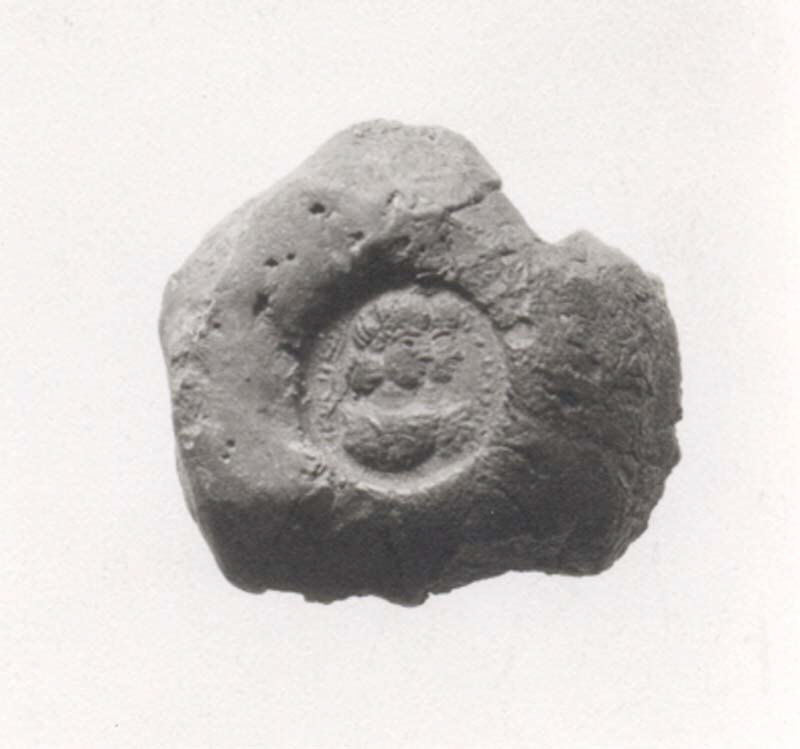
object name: sealing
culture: sasanian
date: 601-700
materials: clay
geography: iran